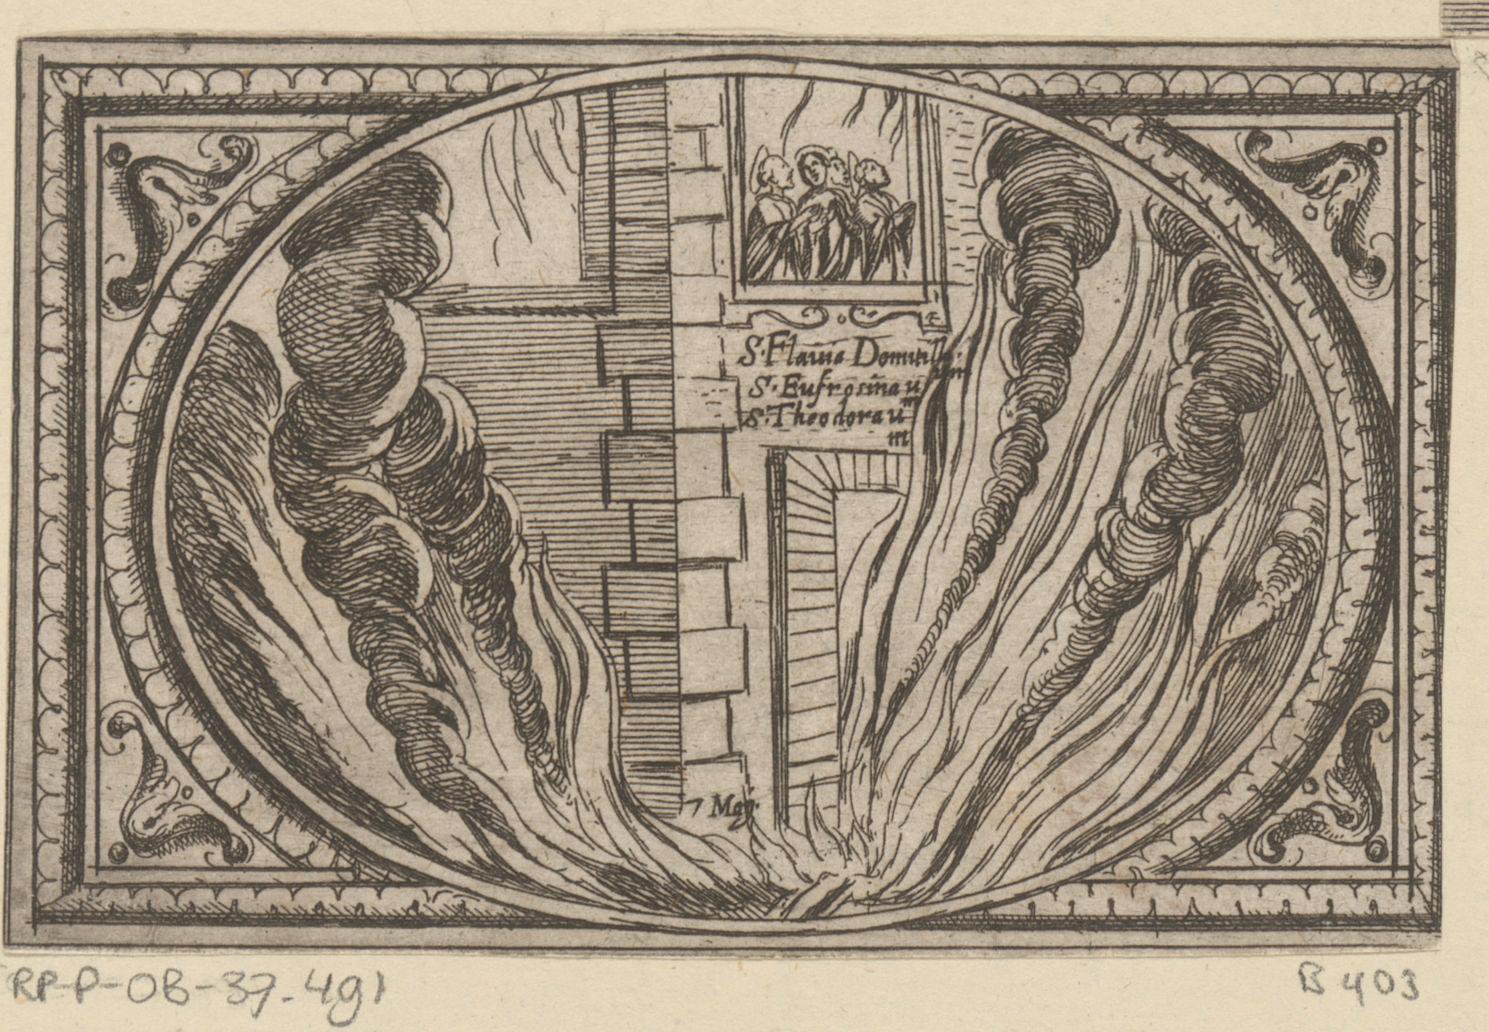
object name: print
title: H. Flavia Domitilla, H. Euphrosyna en H. Theodora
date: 1565-1630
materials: paper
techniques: etching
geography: rome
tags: on fire, ablaze, martyr(s) (often with palm-branches) - qq - female martyr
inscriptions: collector's mark: Lugt 240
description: Vier martelaressen, waarvan de heilige Flavia Domitilla, de heilige Eufrosina en de heilige Theodora met naam worden genoemd, in een brandend gebouw.